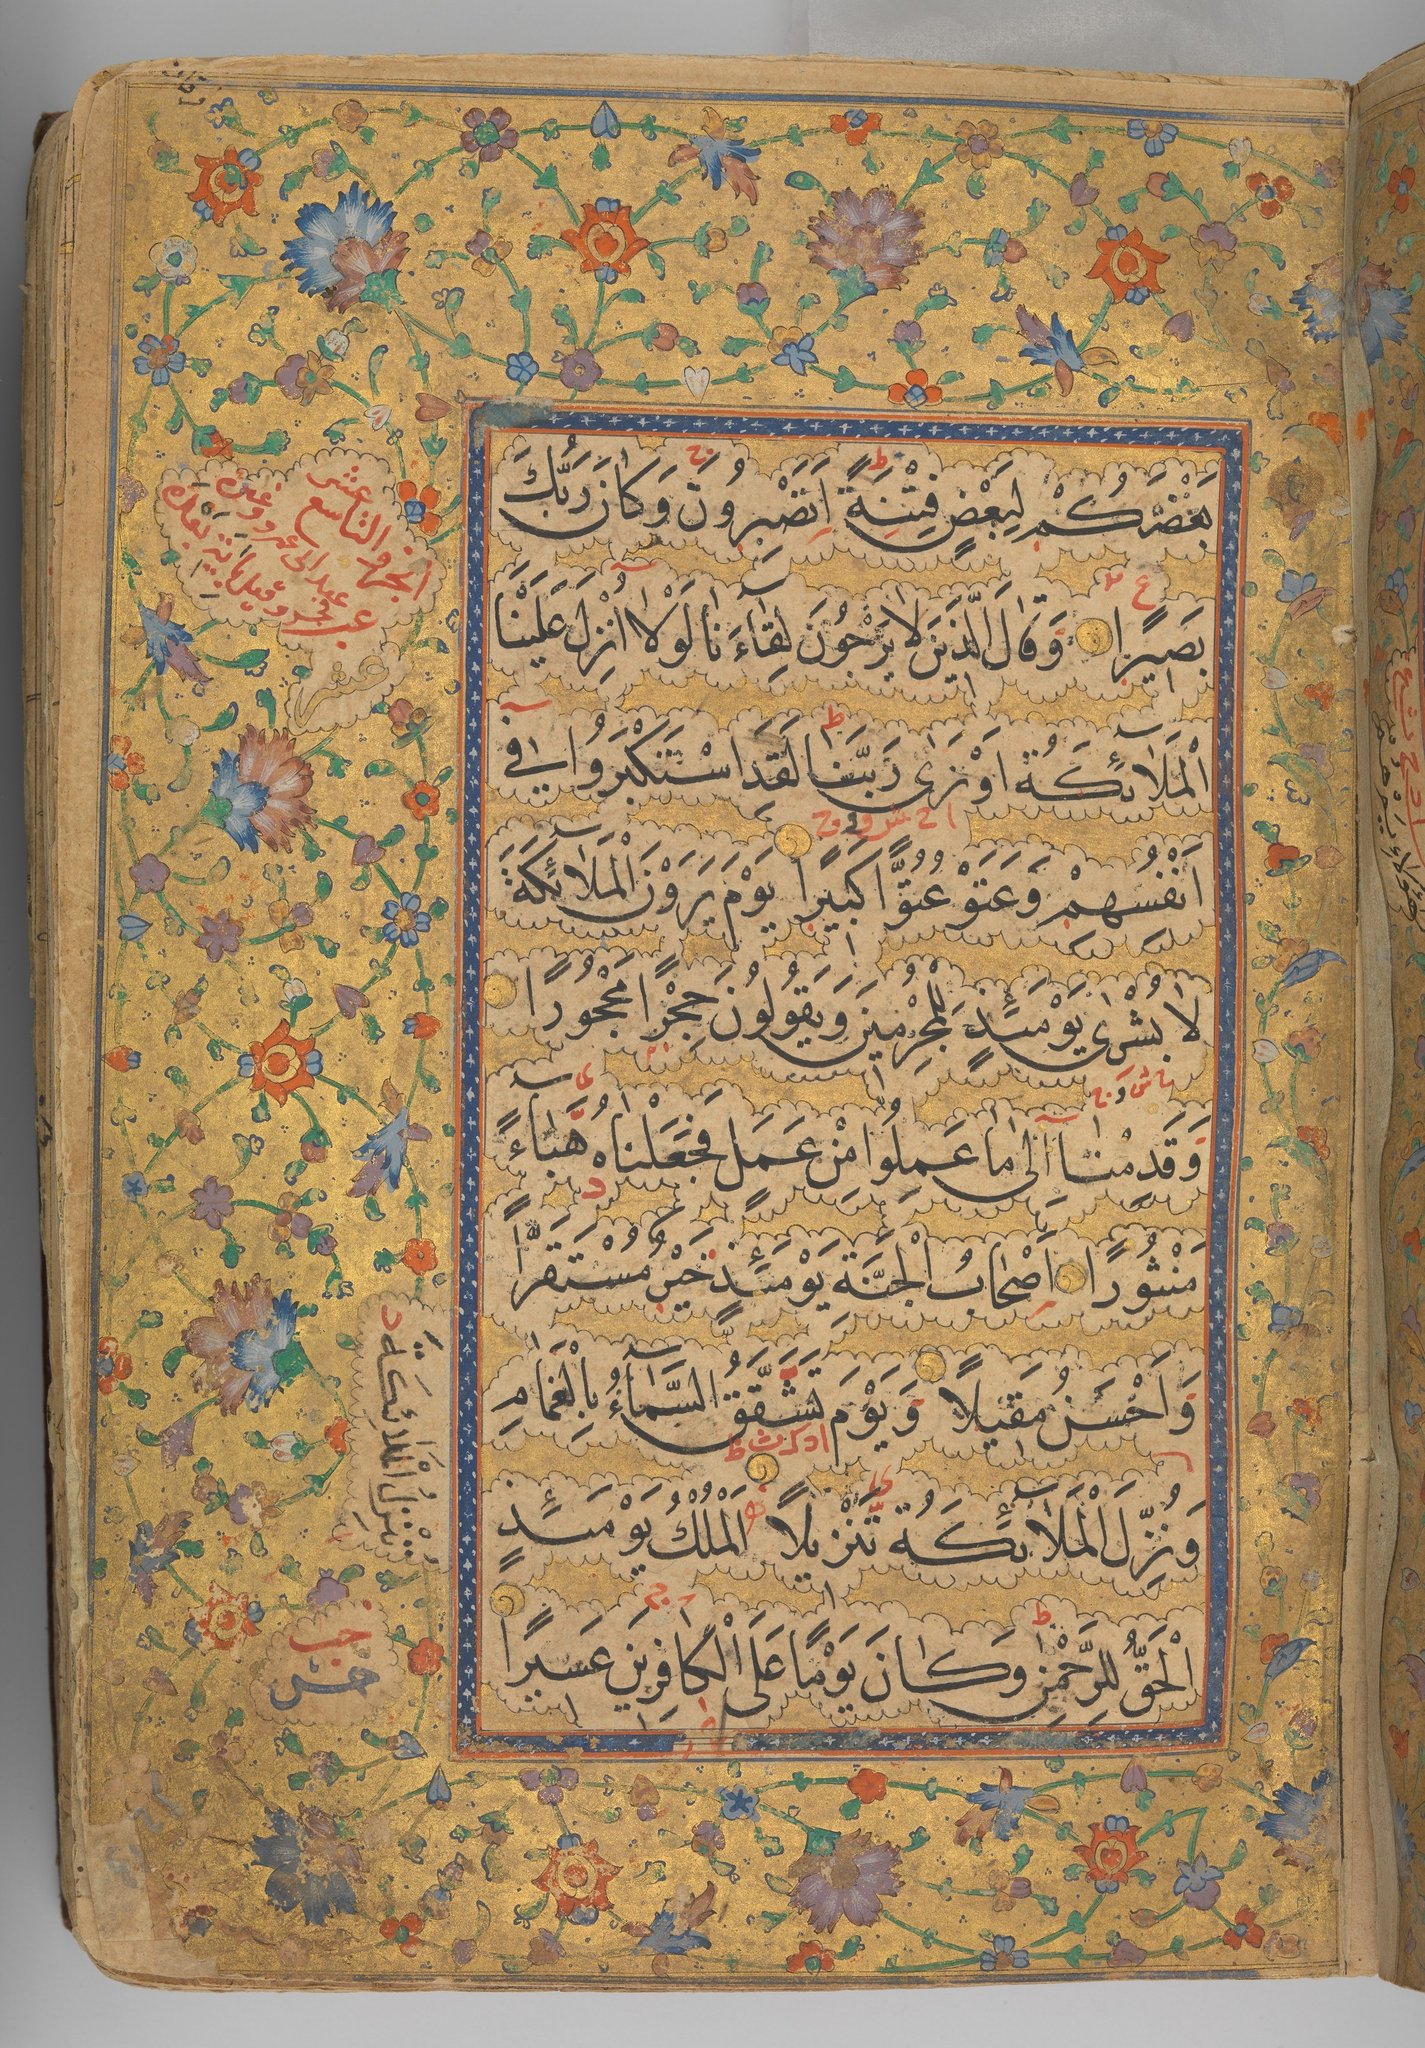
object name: non illustrated manuscript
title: Qur'an of Ibrahim Sultan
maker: ibrahim sultan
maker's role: calligrapher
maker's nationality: iranian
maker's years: 1370-1435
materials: gold, ink, leather, paper, watercolor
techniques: bookbinding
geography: iran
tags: arabic,flowers